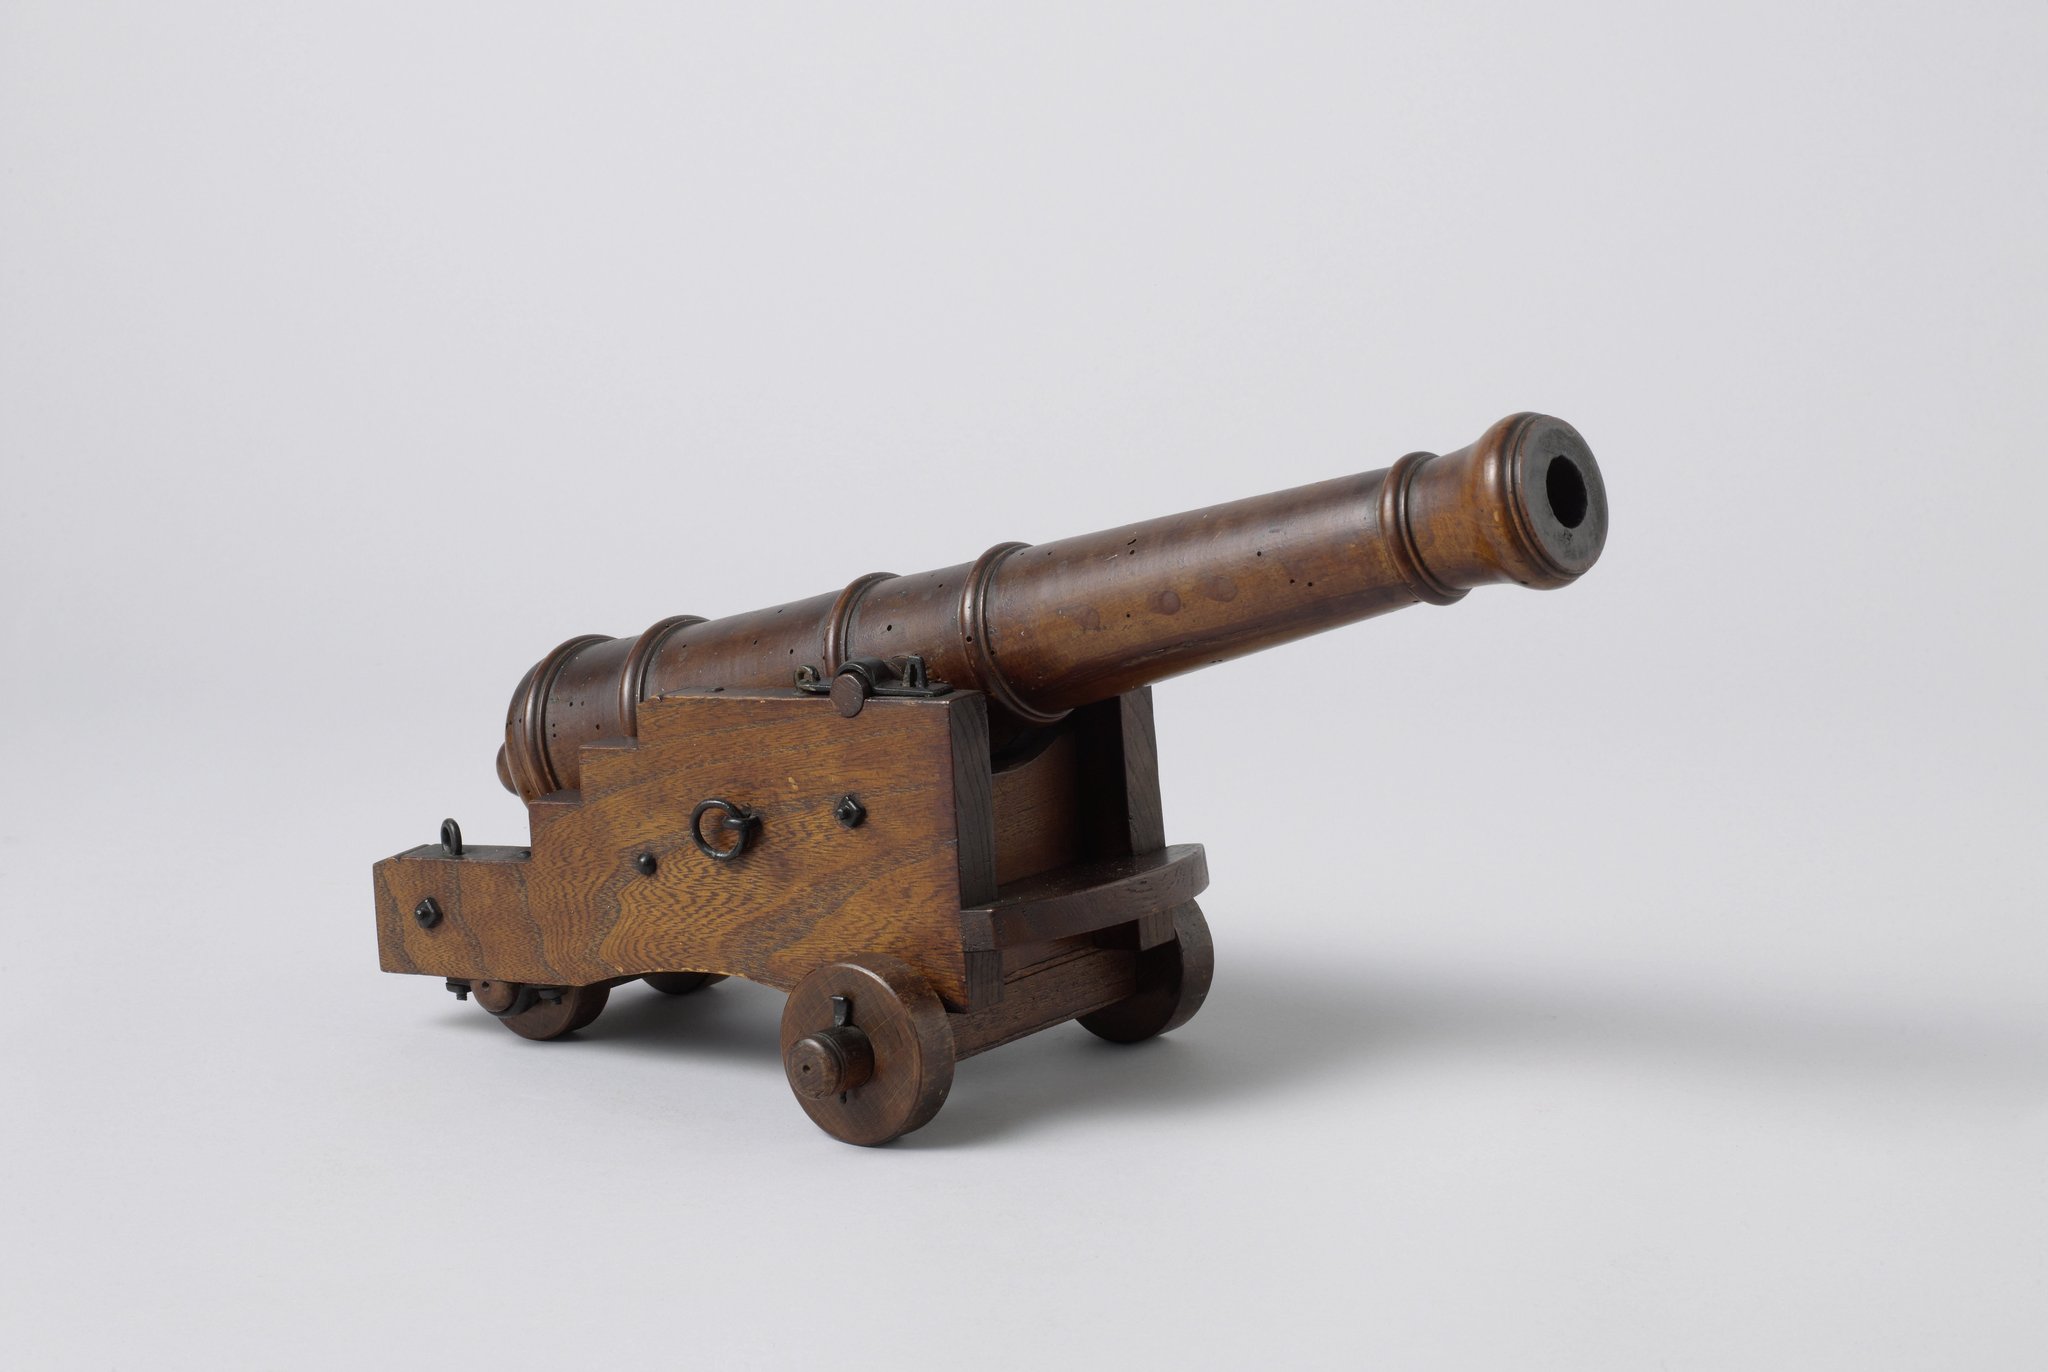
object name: demonstration model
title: Model of a 12-Pounder Gun on a Carriage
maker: Anonymous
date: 1780-1800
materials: iron, wood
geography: rotterdam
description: Model van een kanon van 12 pond op rolpaard. De 41,4 cm lange loop heeft een kaliber van 19 mm. De wangen van het rolpaard, met drie trappen en een boogvormige uitsnede onderaan, staan achter verder uit elkaar dan voor en zijn verbonden door het kalf, het borststuk, de zoolplaat, het voorste aslijf en drie bouten dwars door de wangen. De stelwig en het elevatieplateau ontbreken. De wielen zijn van hout, de voorwielen zijn groter dan de achterwielen; de achterwielen zijn tussen de wangen onder de zoolplaat aangebracht. Schaal 1:6 (vermoedelijk).